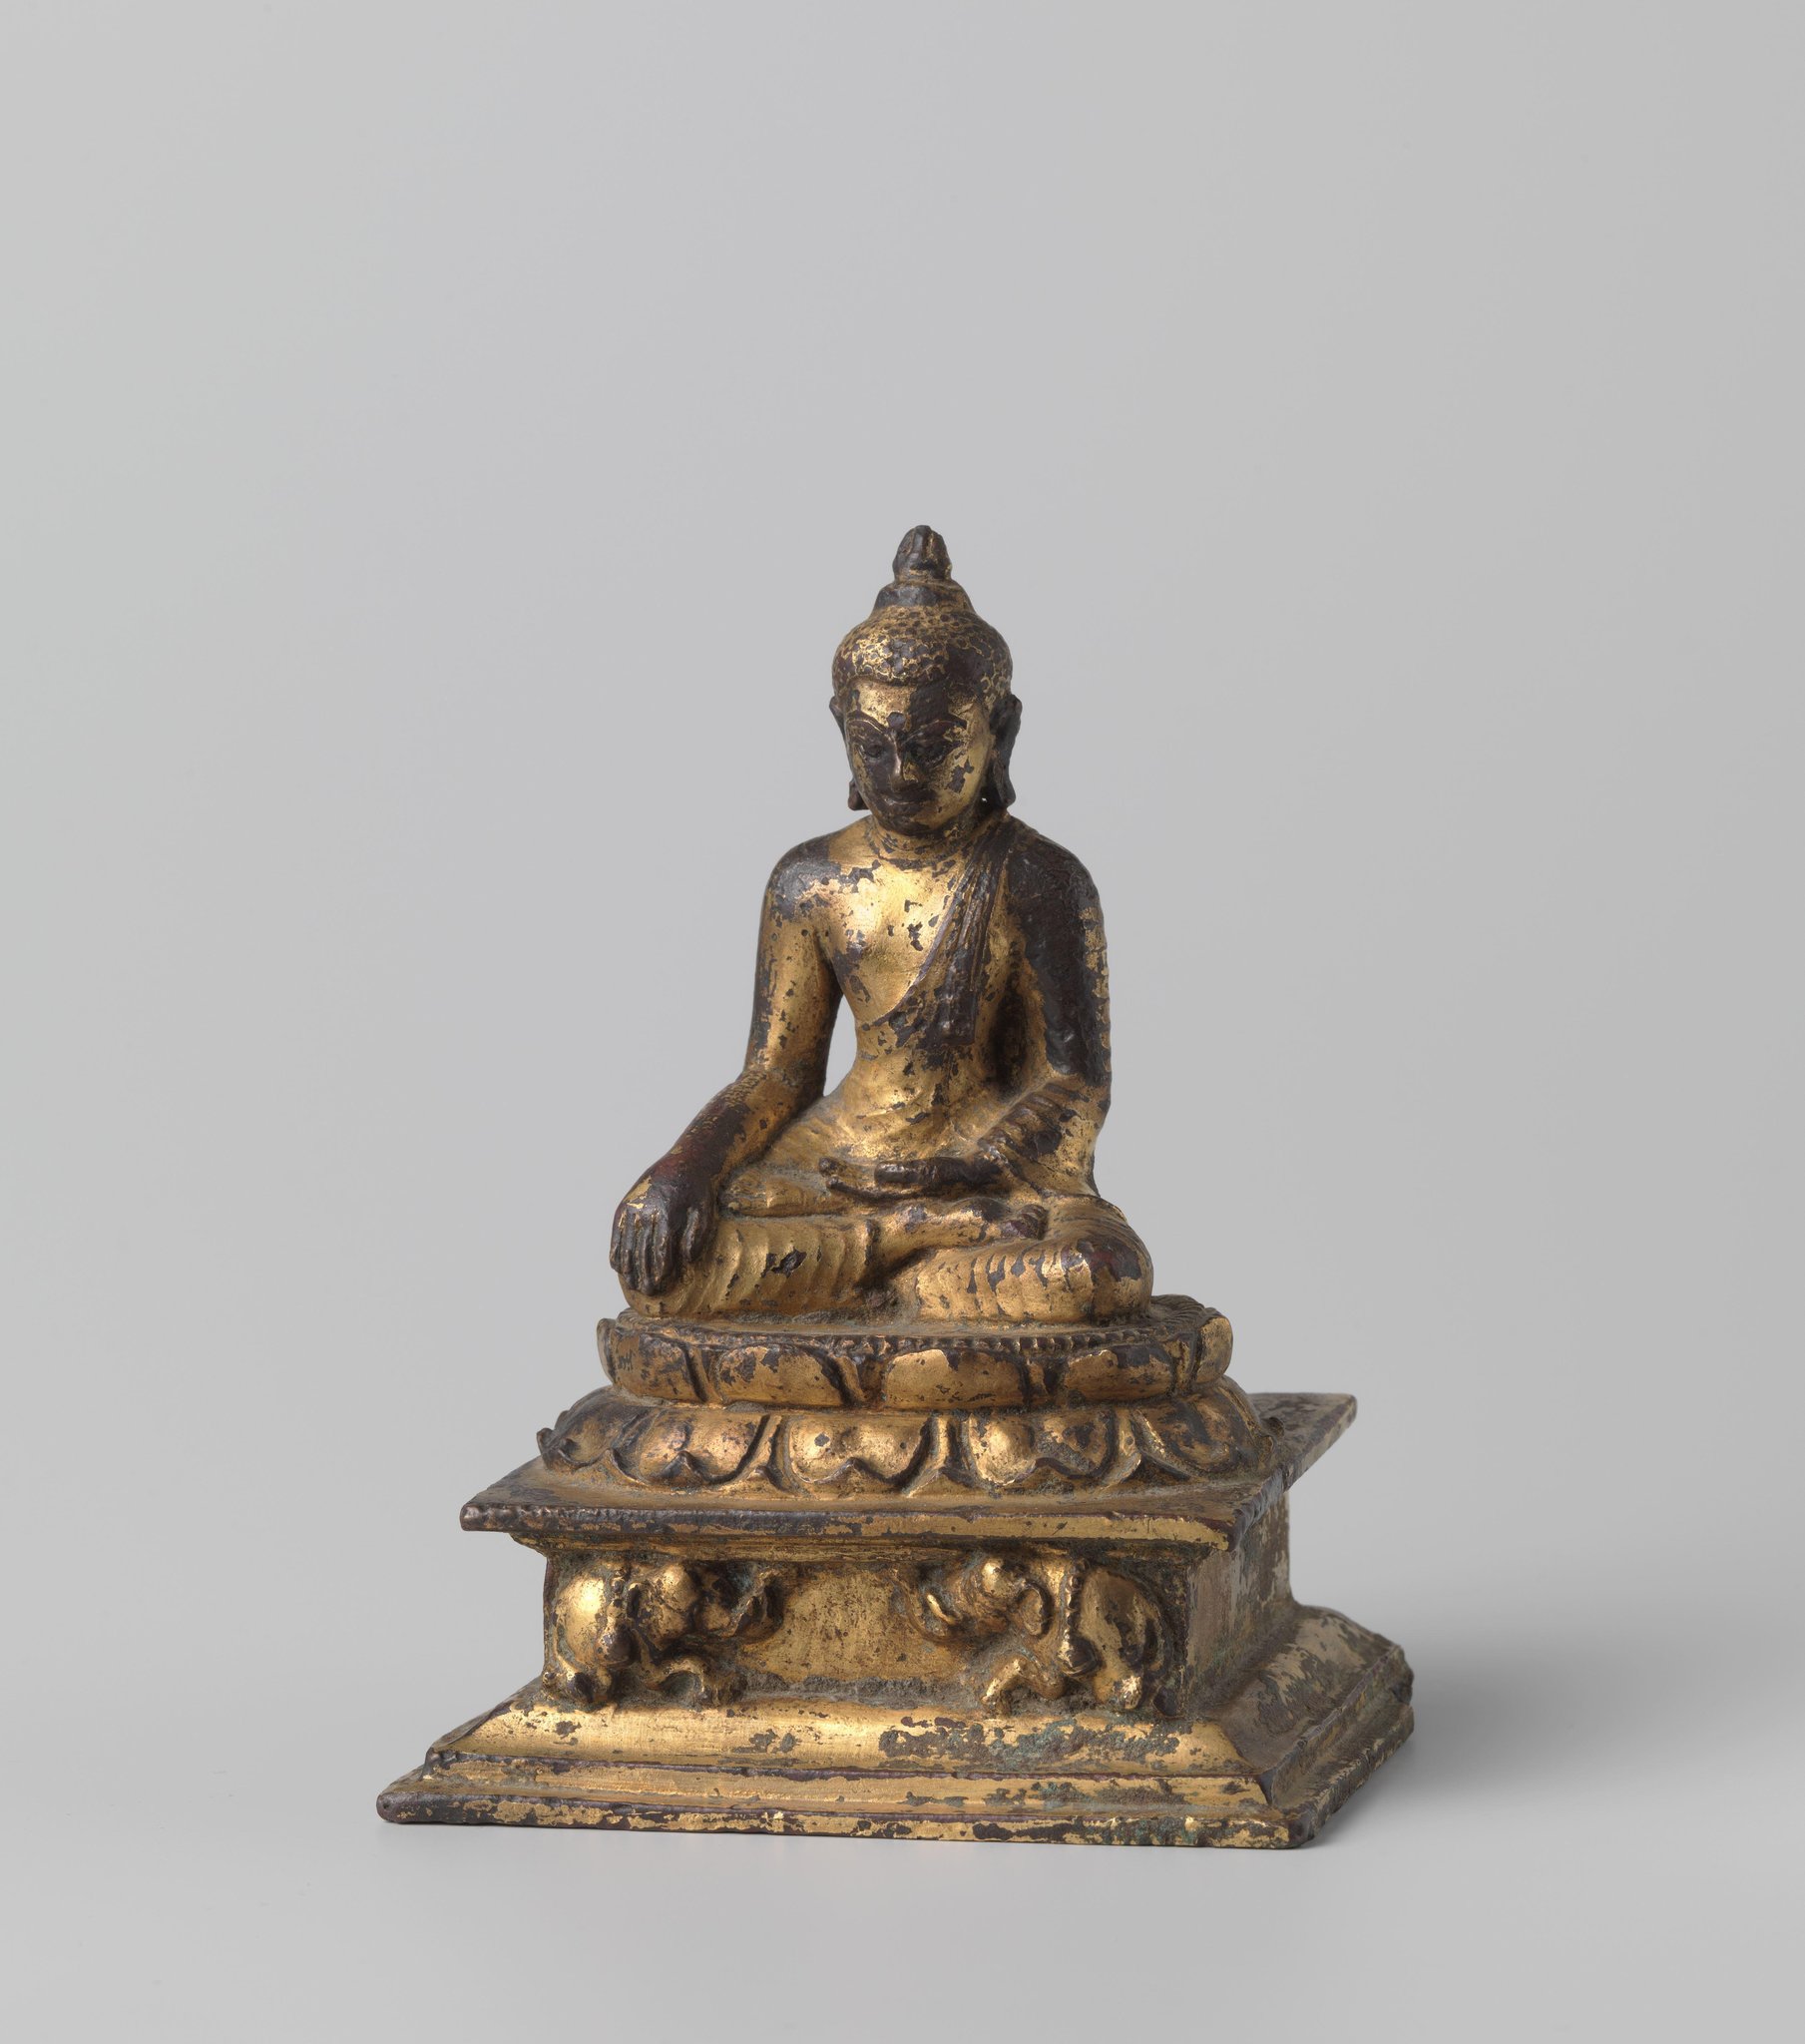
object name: boeddha kop, boeddha beeld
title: Seated Buddha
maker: Anonymous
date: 900-1000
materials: bronze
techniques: gilding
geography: burma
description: The Buddha is here shown seated wearing the robes of a monk, his right hand folded downwards over his knee. This gesture refers to the fact that during meditation he touched the earth in order to defeat the forces of Mara, or illusion. Although gilded and decorated with depictions of two royal elephants on the base, this image nevertheless emphasizes stillness and serenity.